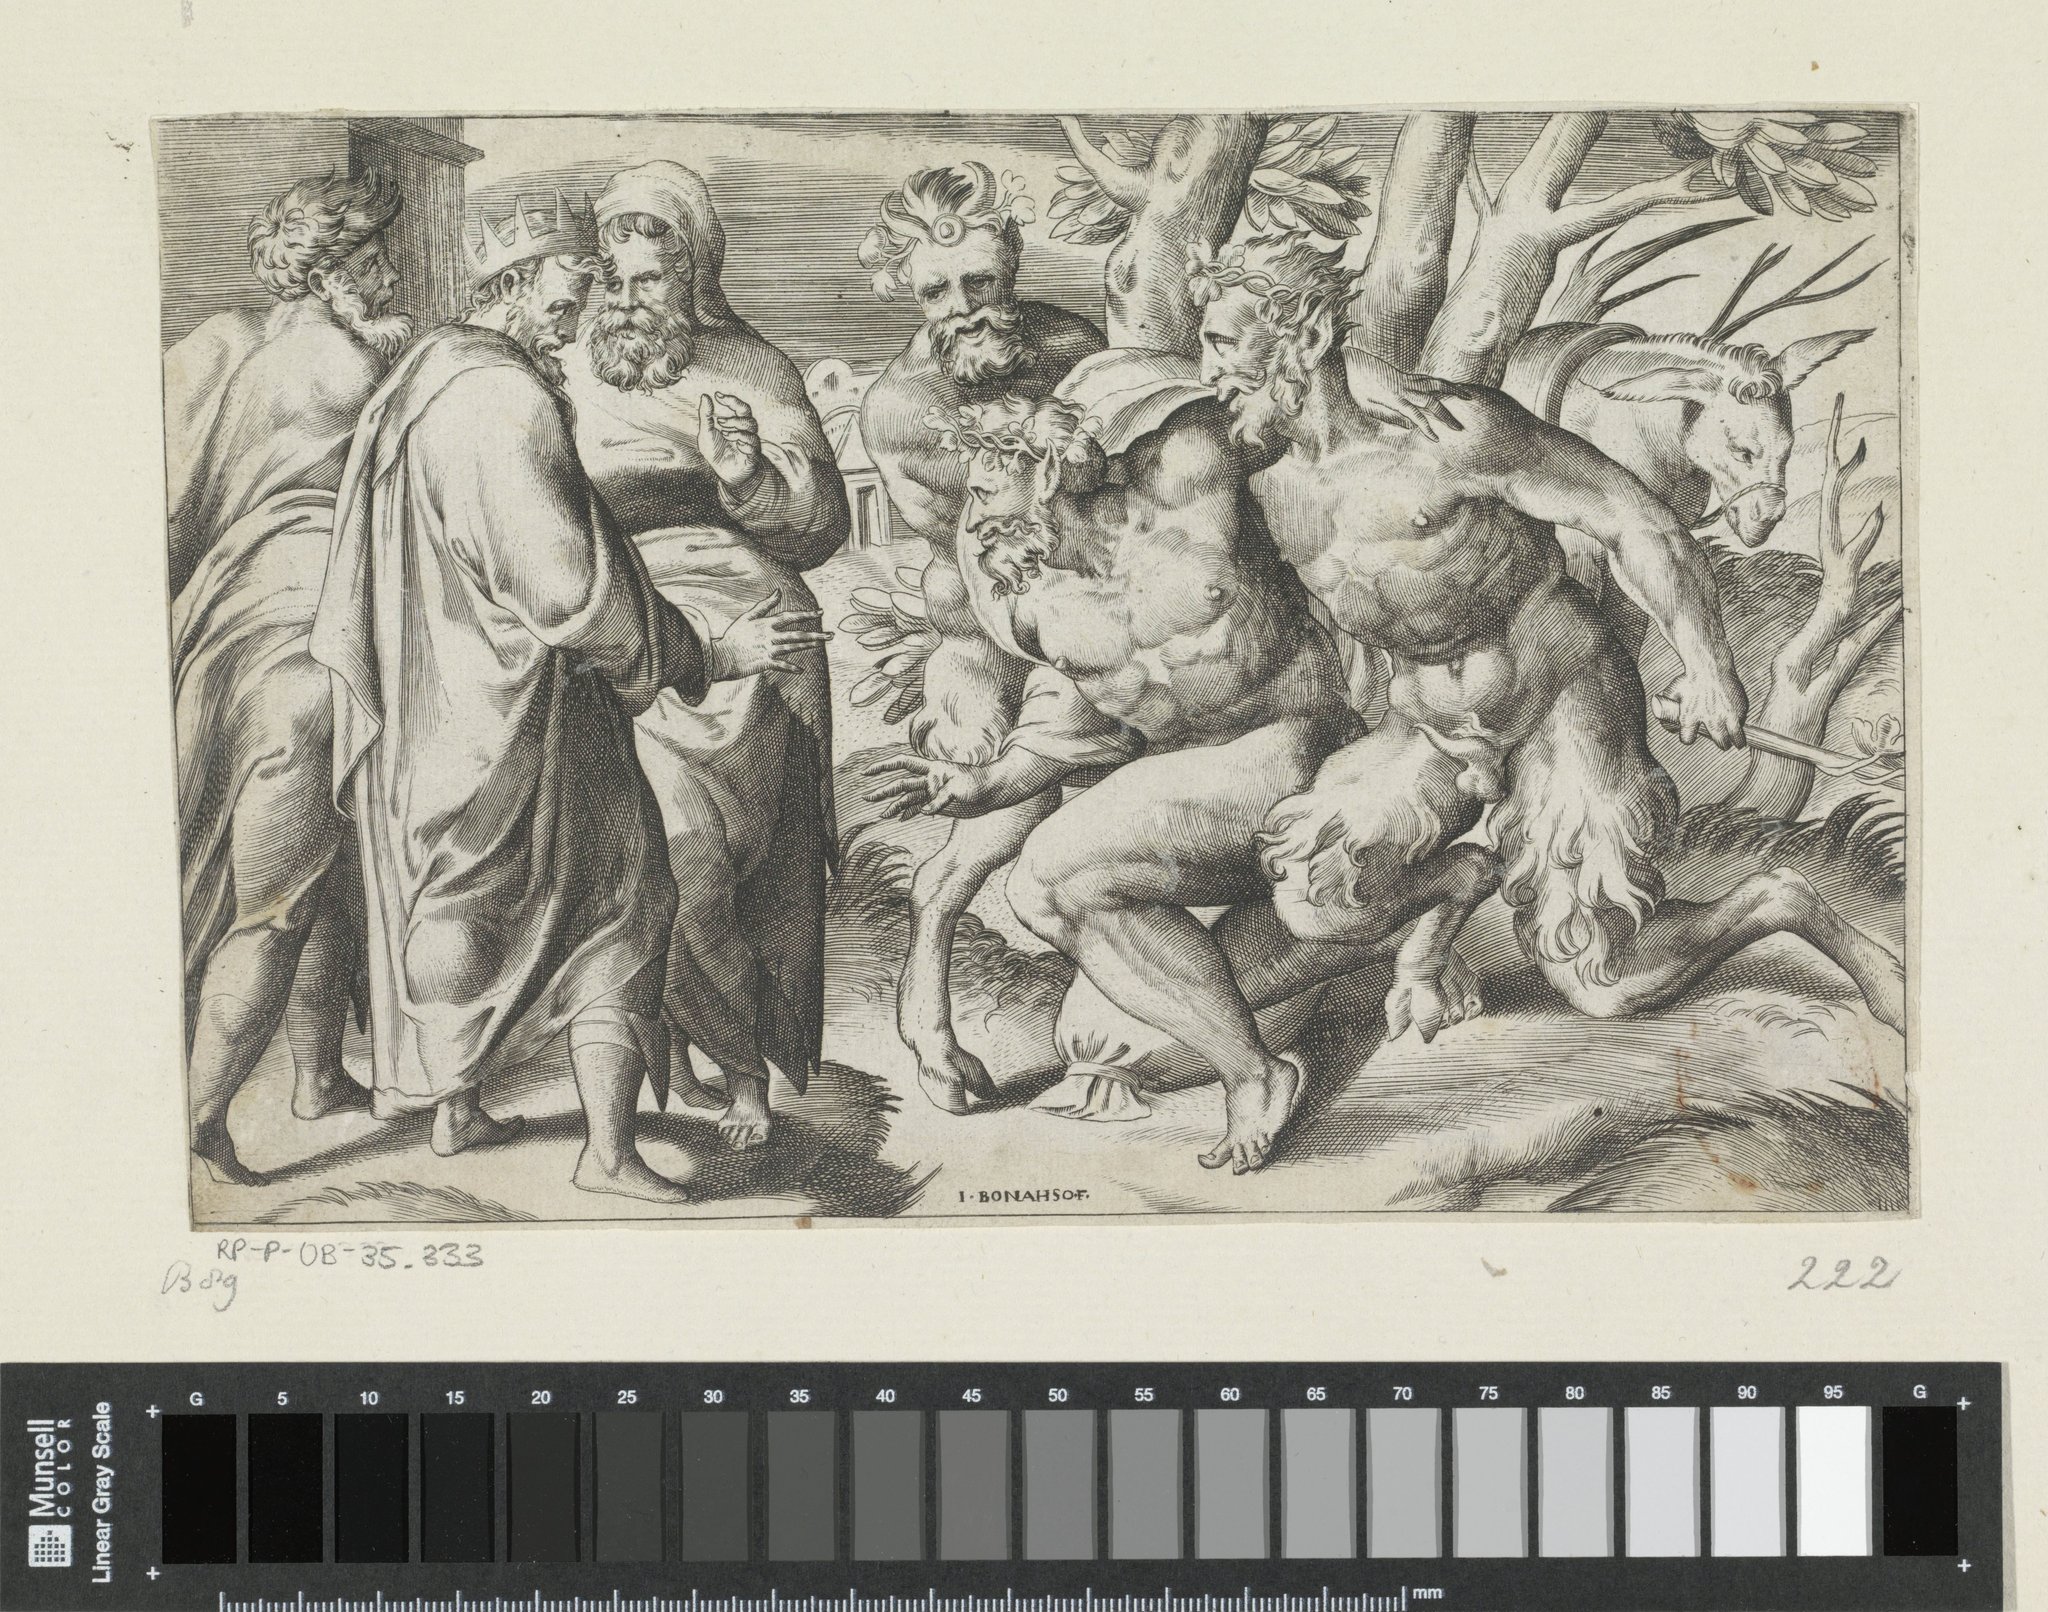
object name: print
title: Twee saters brengen Silenus bij koning Midas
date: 1501-1580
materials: paper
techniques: engraving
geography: italy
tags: satyr(s) (in general), silenus amicably entertained by midas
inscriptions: collector's mark: Lugt 240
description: Blanco ondermarge afgesneden. Mogelijk naar een tekening door Perino del Vaga naar een antiek reliëf.